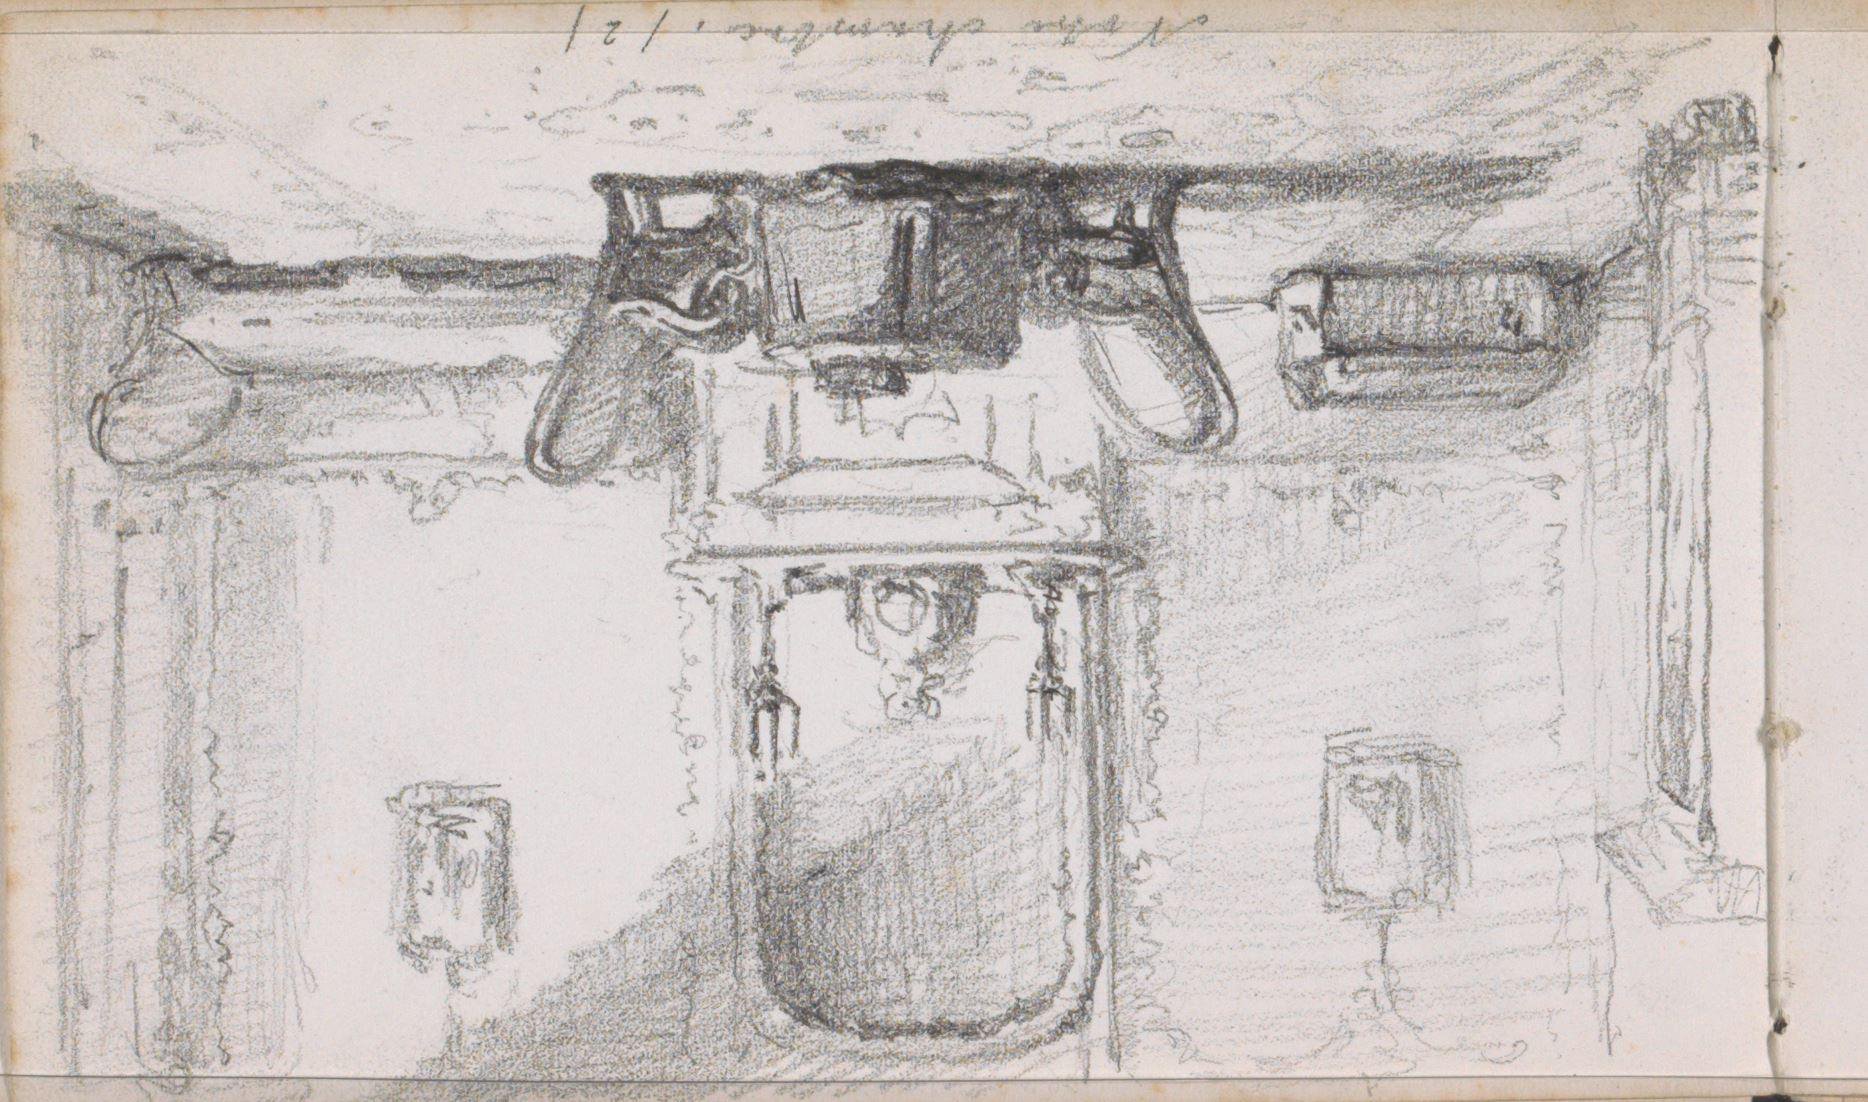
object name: sketchbook leaf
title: Zitkamer met een tafel, twee stoelen en een bank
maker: maria vos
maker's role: draughtsman, painter, print maker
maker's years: 1824-1906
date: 1811-1867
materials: paper, pencil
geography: paris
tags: living-room, parlour, sitting-room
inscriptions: annotation: ‘Notre chambre /2/’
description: Blad 20 verso uit een schetsboek met 40 bladen.